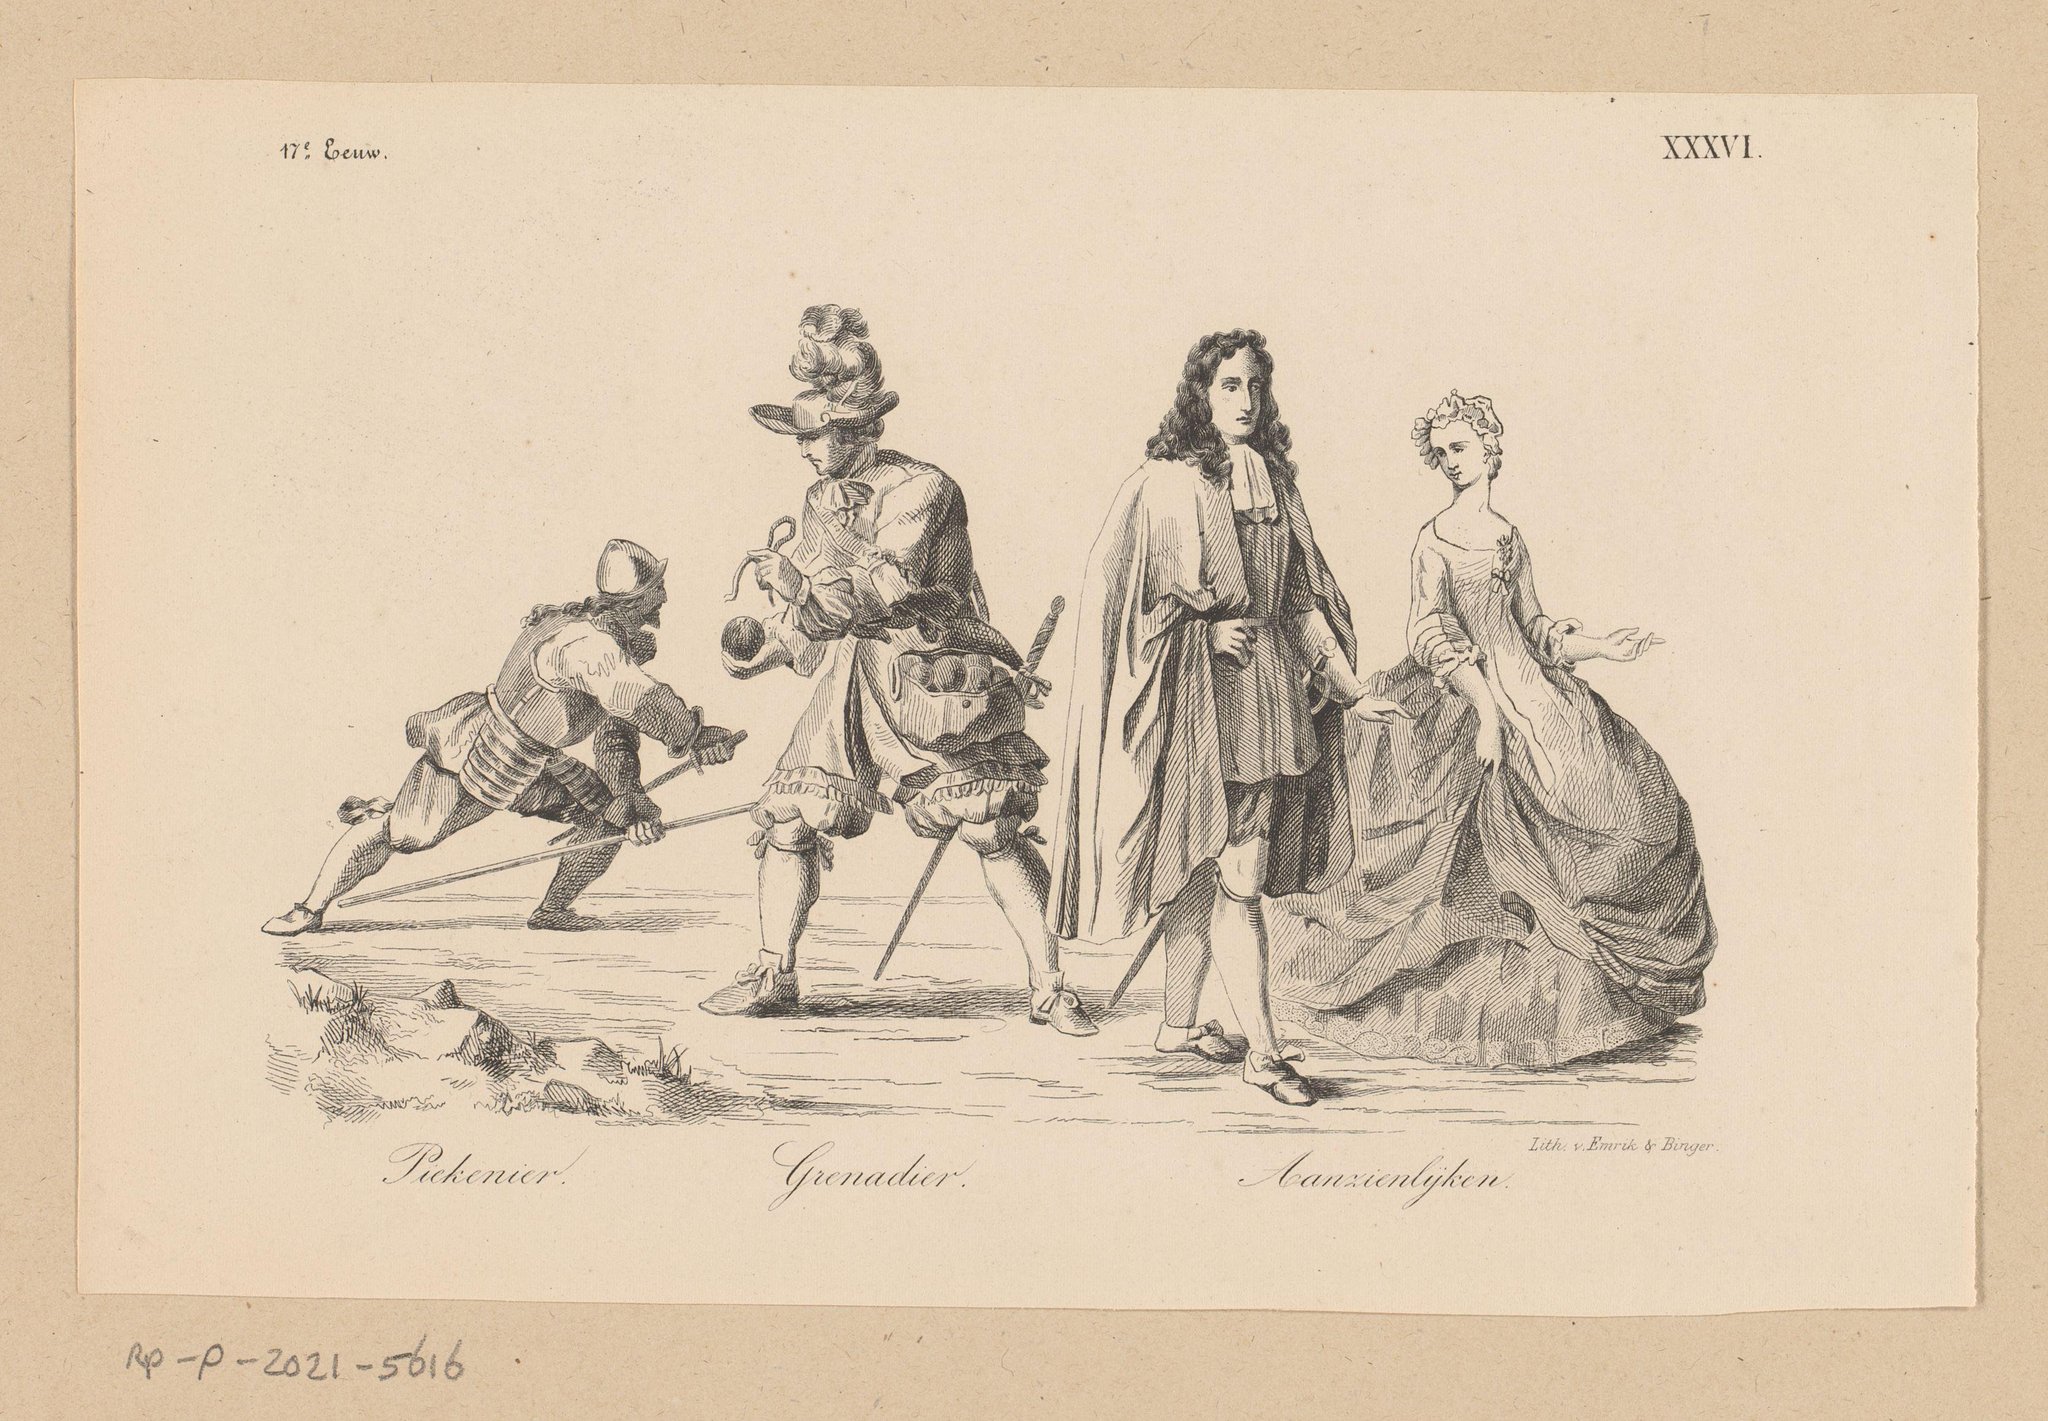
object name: costume print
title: Piekenier, grenadier en rijke man en vrouw in kleding uit de zeventiende eeuw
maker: Anonymous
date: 1857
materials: paper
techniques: lithograph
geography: haarlem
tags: helved weapons, polearms (for striking, hacking, thrusting): pike, projectiles, explosives, etc., clothes, costume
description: Prent waarschijnlijk uit: Hofdijk, Willem Jacob. Schets van de geschiedenis der Nederlanden. Amsterdam: Gebroeders Binger, 1857.